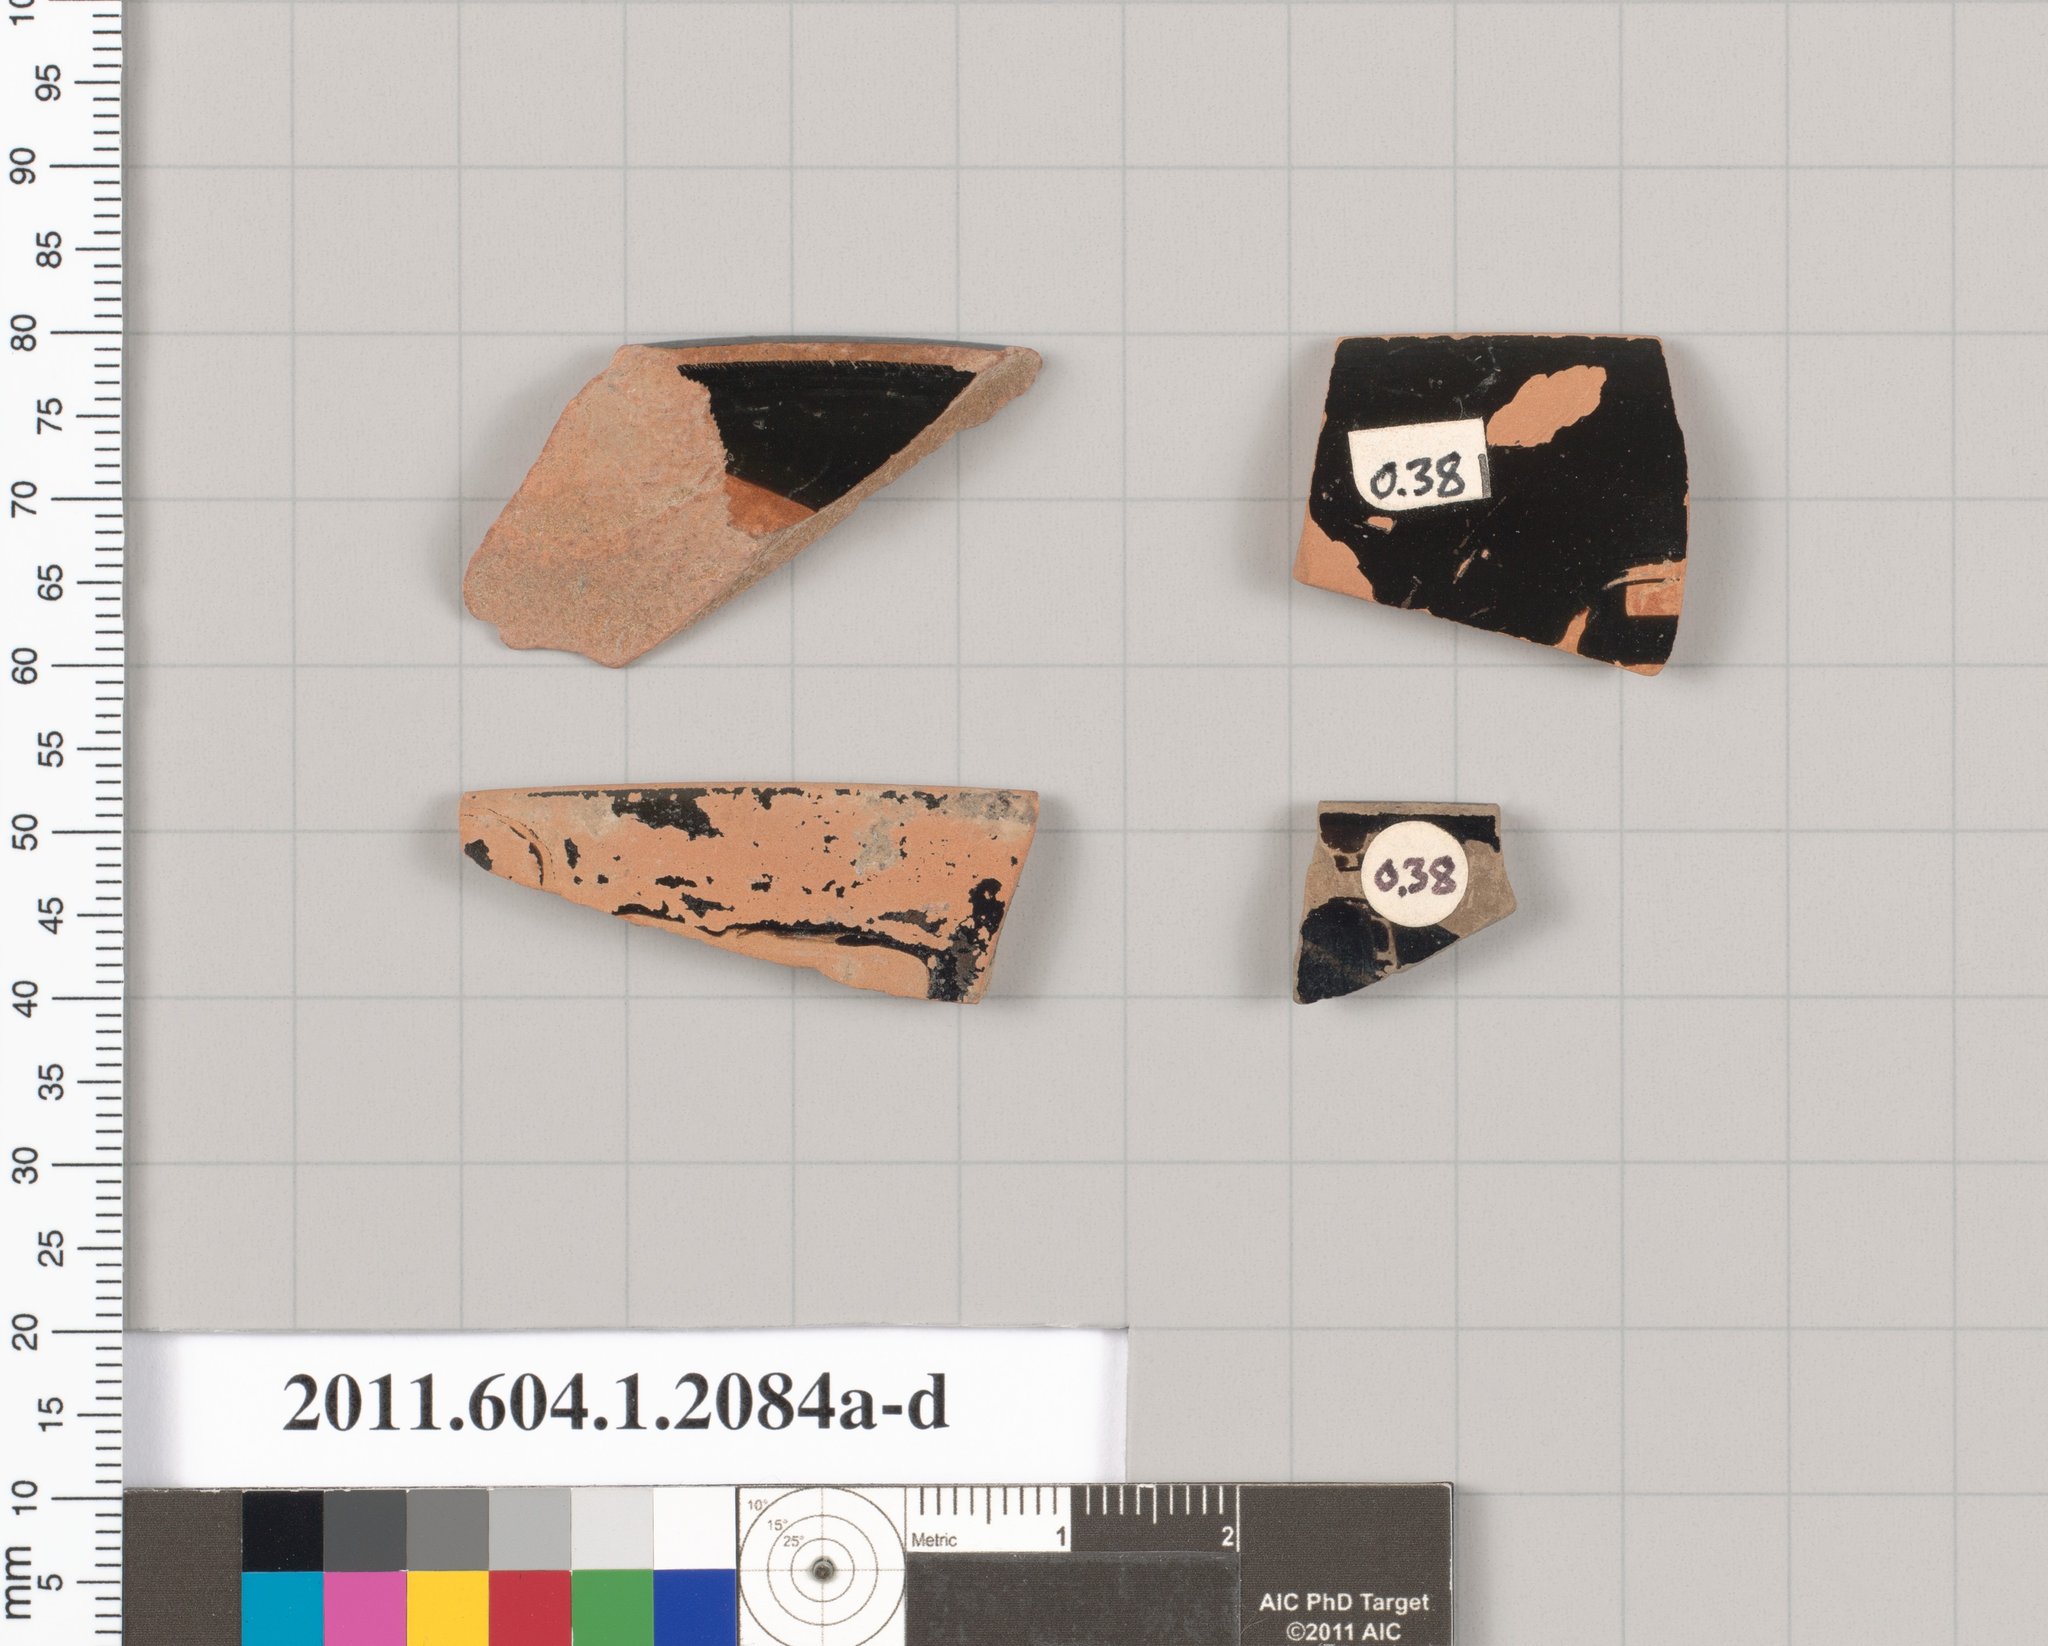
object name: kylix fragment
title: Terracotta rim fragments of kylikes (drinking cups)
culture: greek, attic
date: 500-401 BCE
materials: terracotta